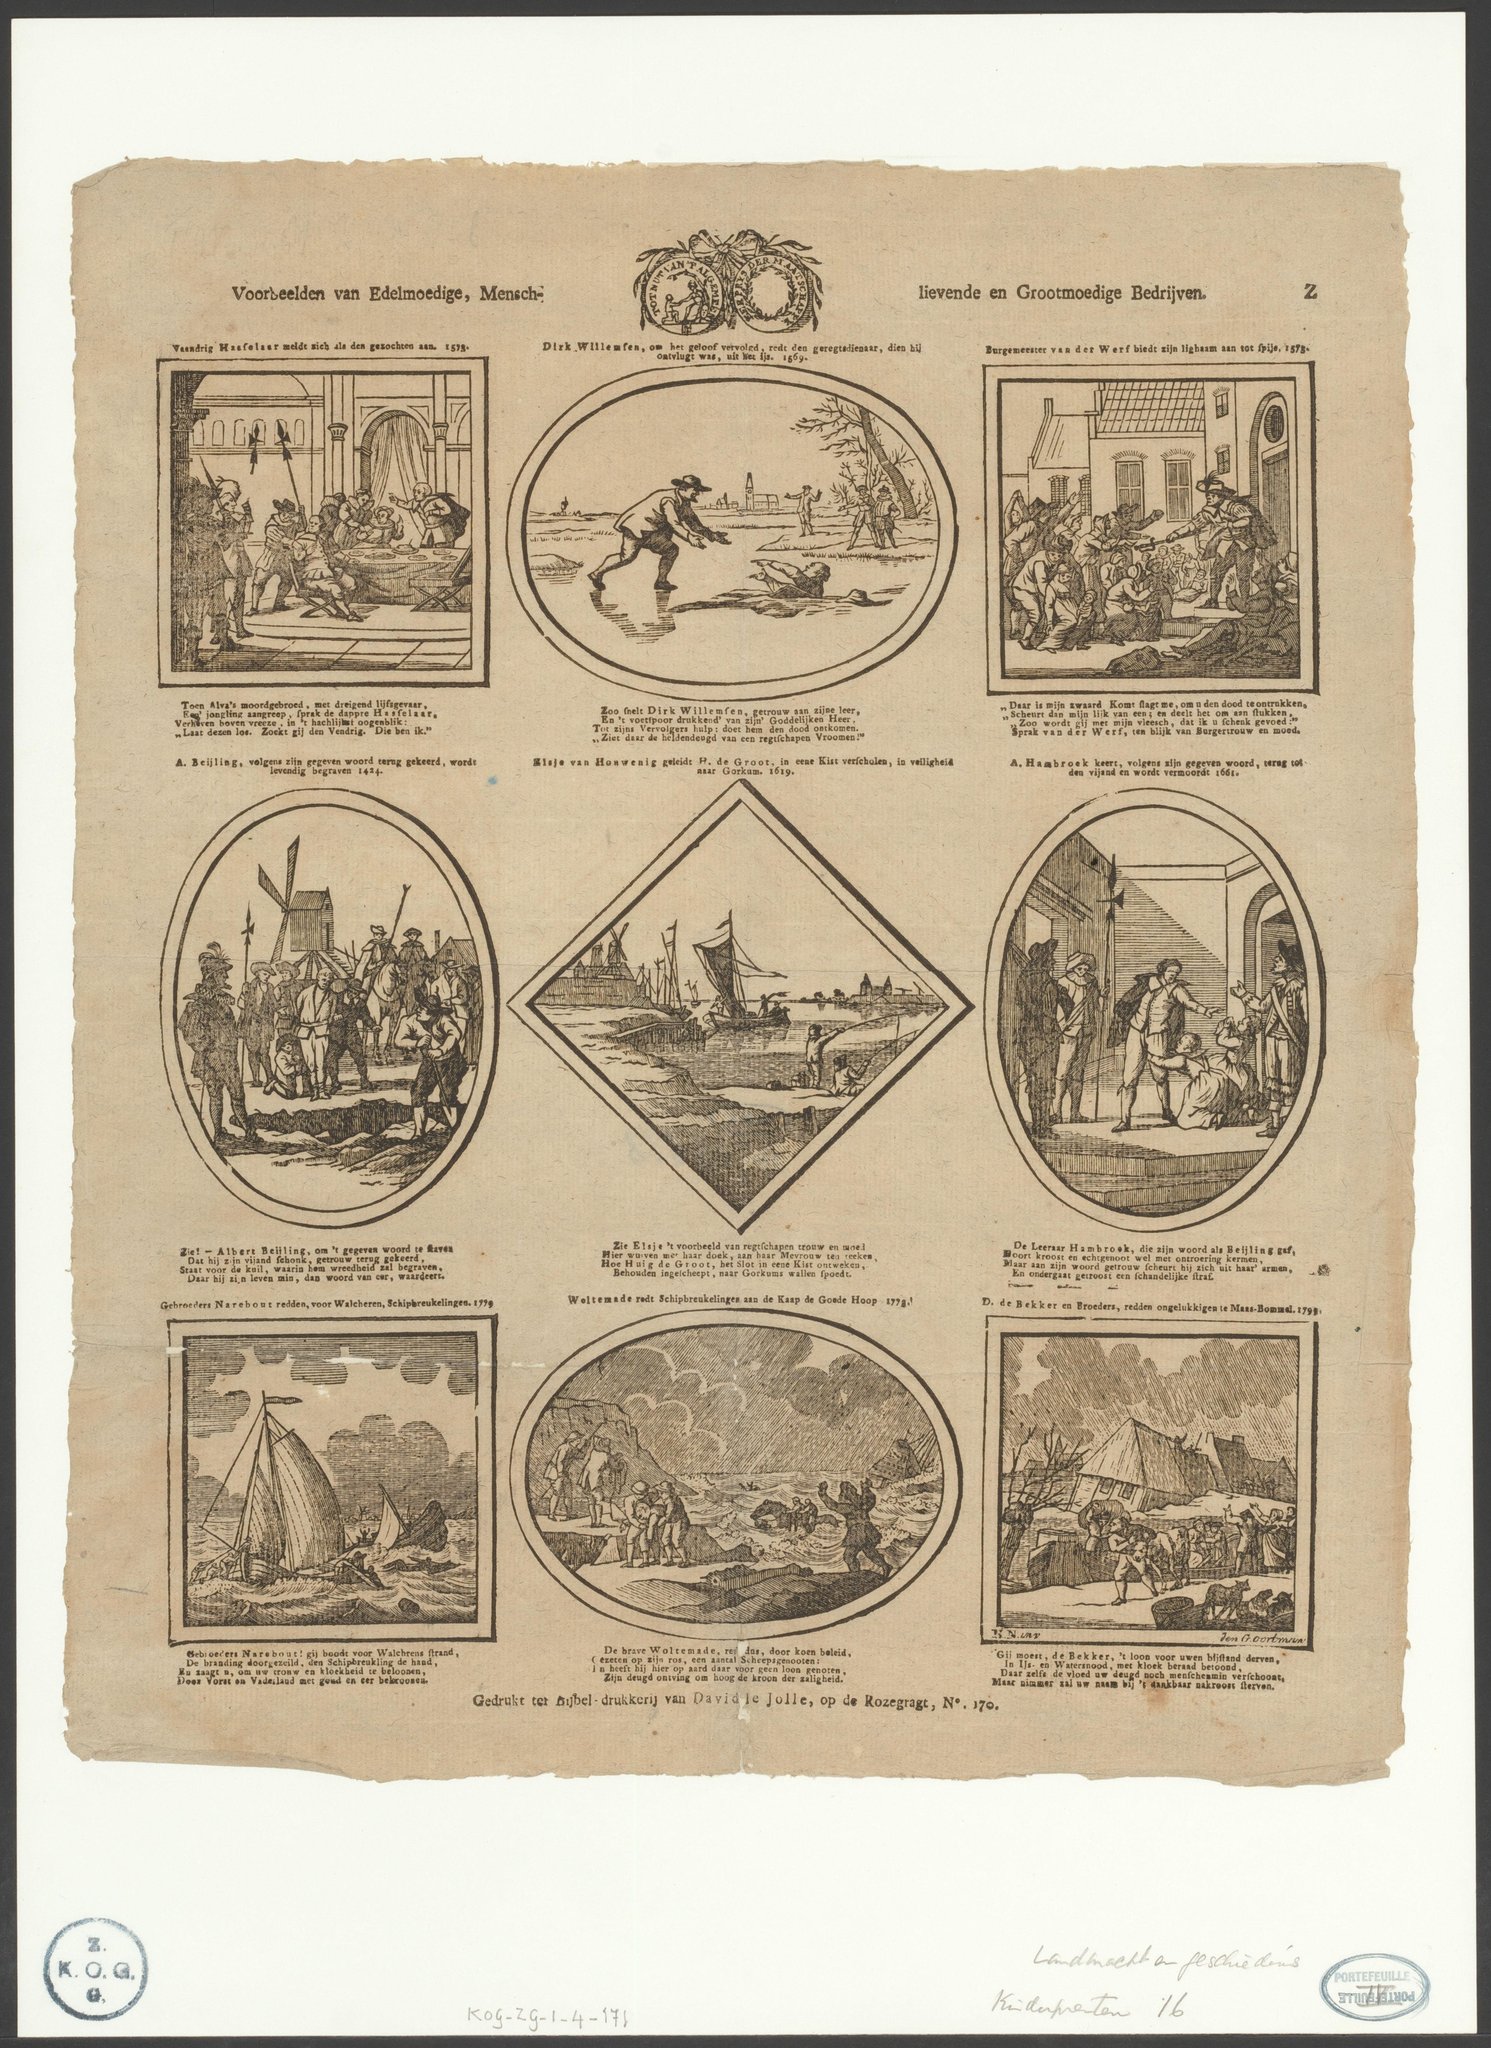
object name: popular print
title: Voorbeelden van edelmoedige, mensch- / lievende en grootmoedige bedrijven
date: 1814-1820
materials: paper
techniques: letterpress printing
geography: netherlands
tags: rotterdam, formosa, unselfishness (+ situation or event (especially in genre-painting) with symbolical connotation)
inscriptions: collector's mark: Lugt 1641, collector's mark:, collector's mark: Lugt 2228